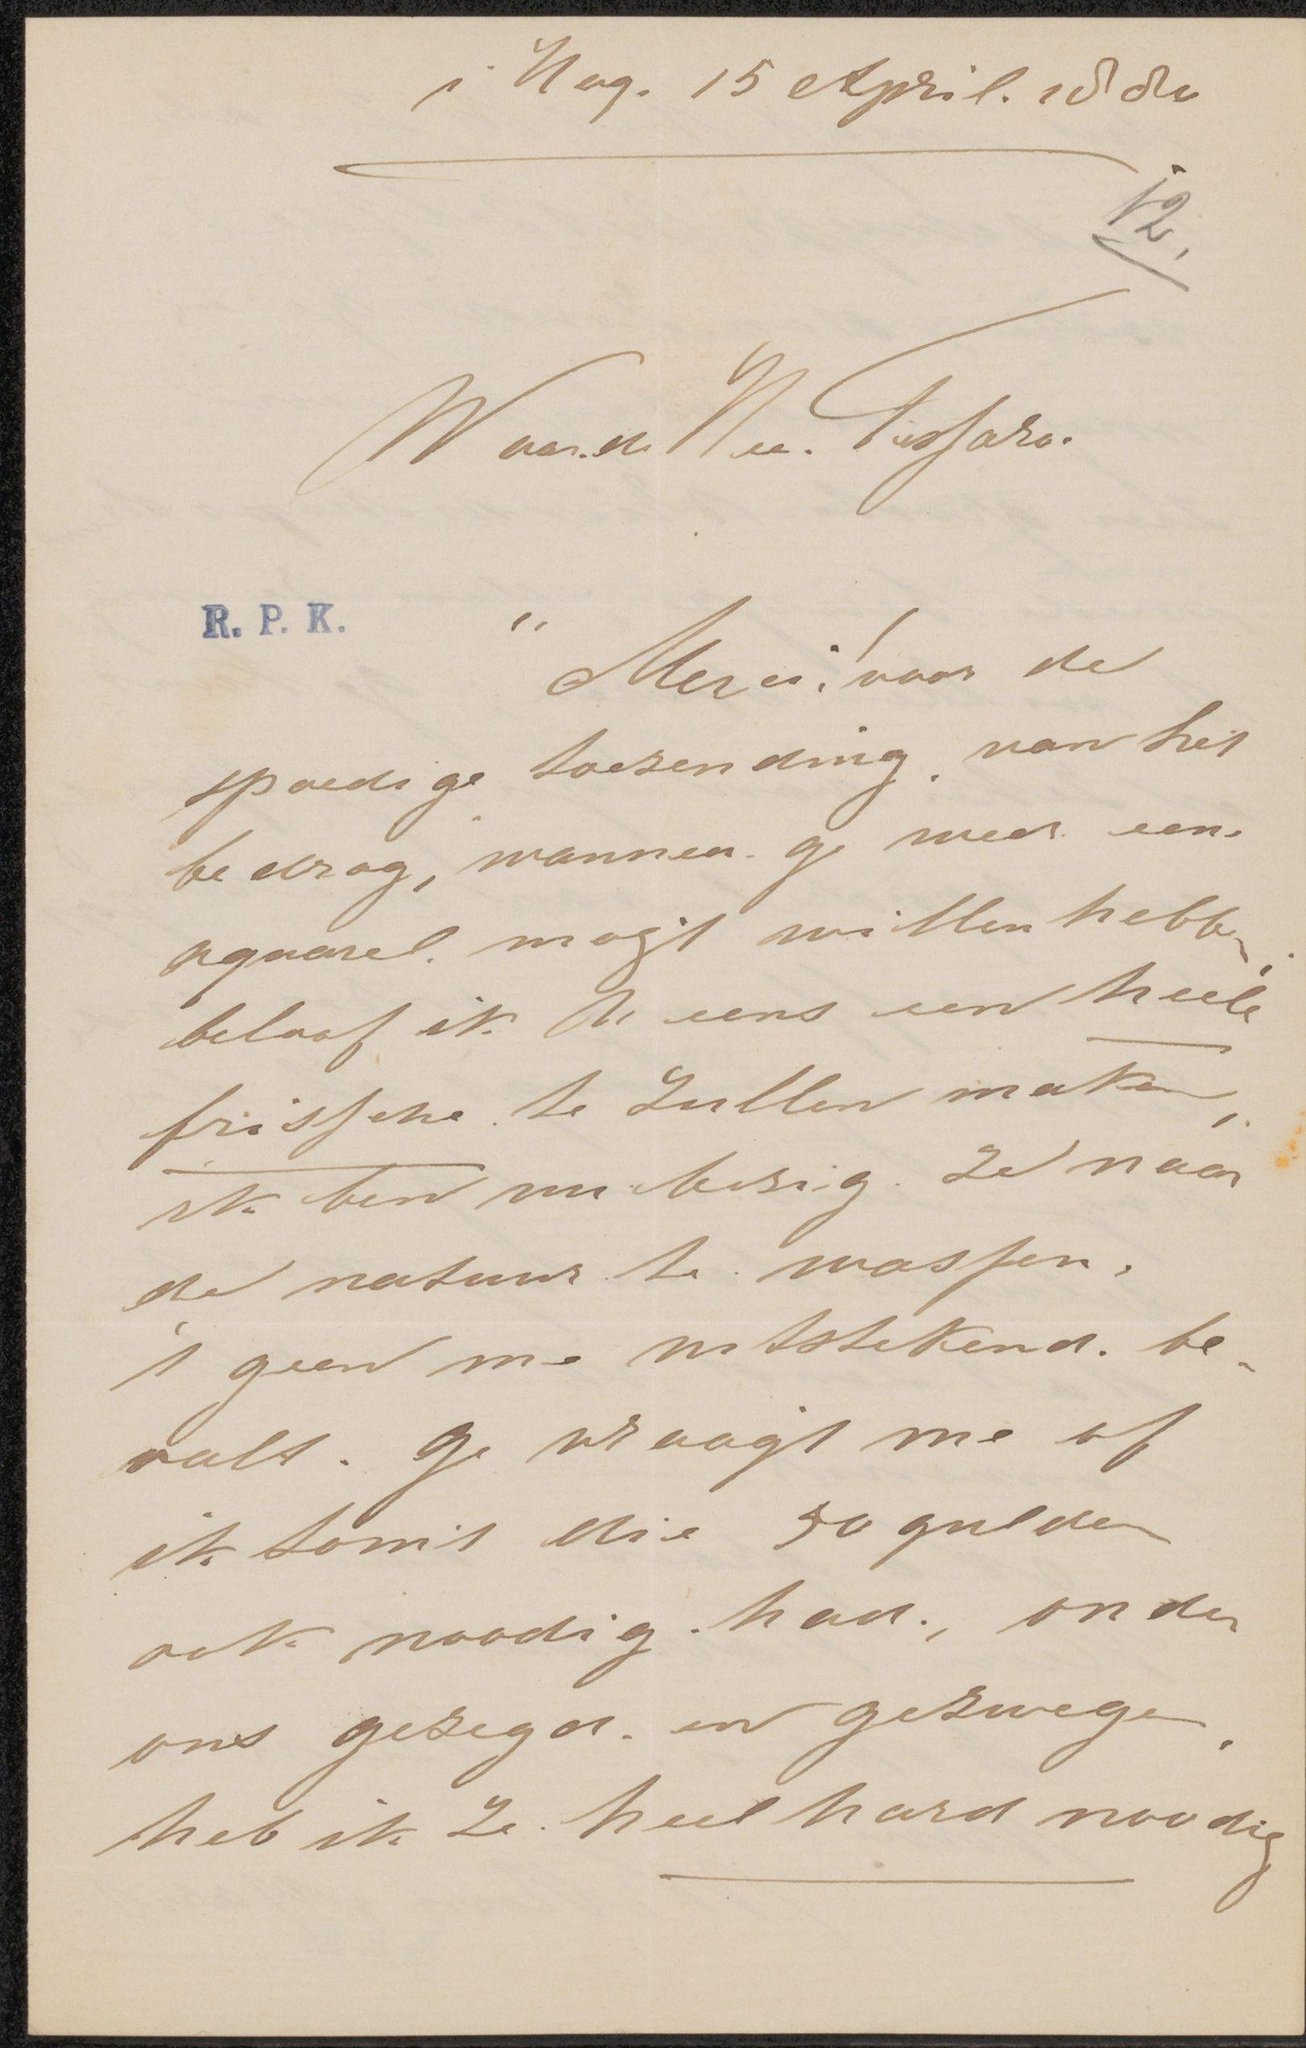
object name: letter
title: Brief aan Filippo Tessaro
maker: willem maris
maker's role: draughtsman, painter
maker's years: 1844-1910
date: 1880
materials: ink, paper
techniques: pen, writing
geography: the hague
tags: art trade, art shop, drawing, money, abcoude, amsterdam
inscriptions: collector's mark: Lugt 2228, collector's mark: Lugt 2233